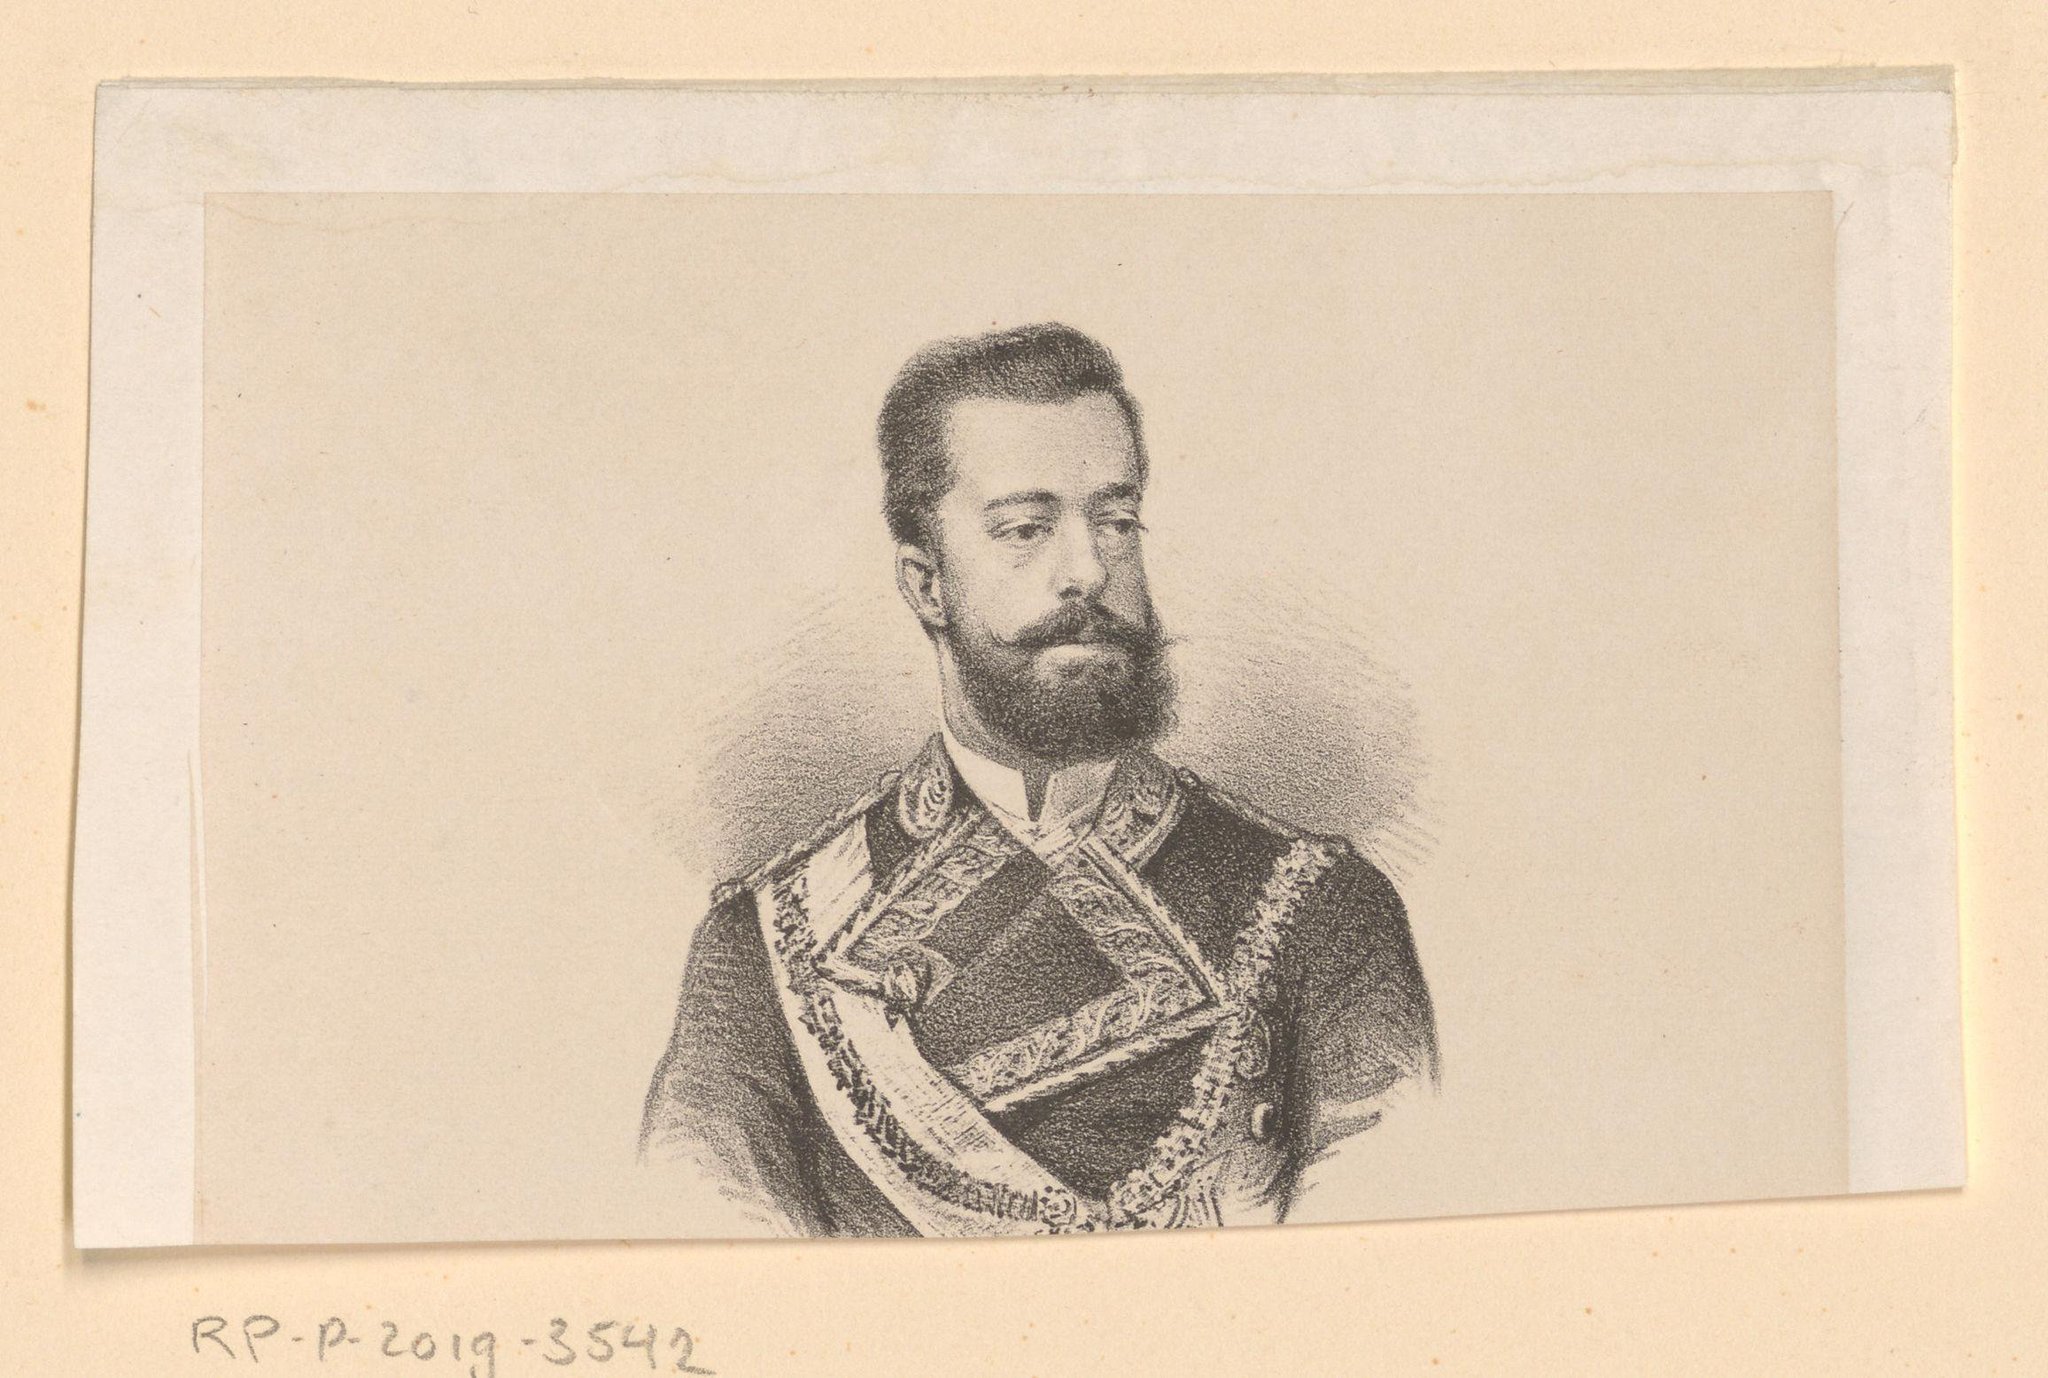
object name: print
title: Portret van Amadeus I, koning van Spanje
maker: Anonymous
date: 1870-1899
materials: paper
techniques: lithograph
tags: historical persons, ruler, sovereign